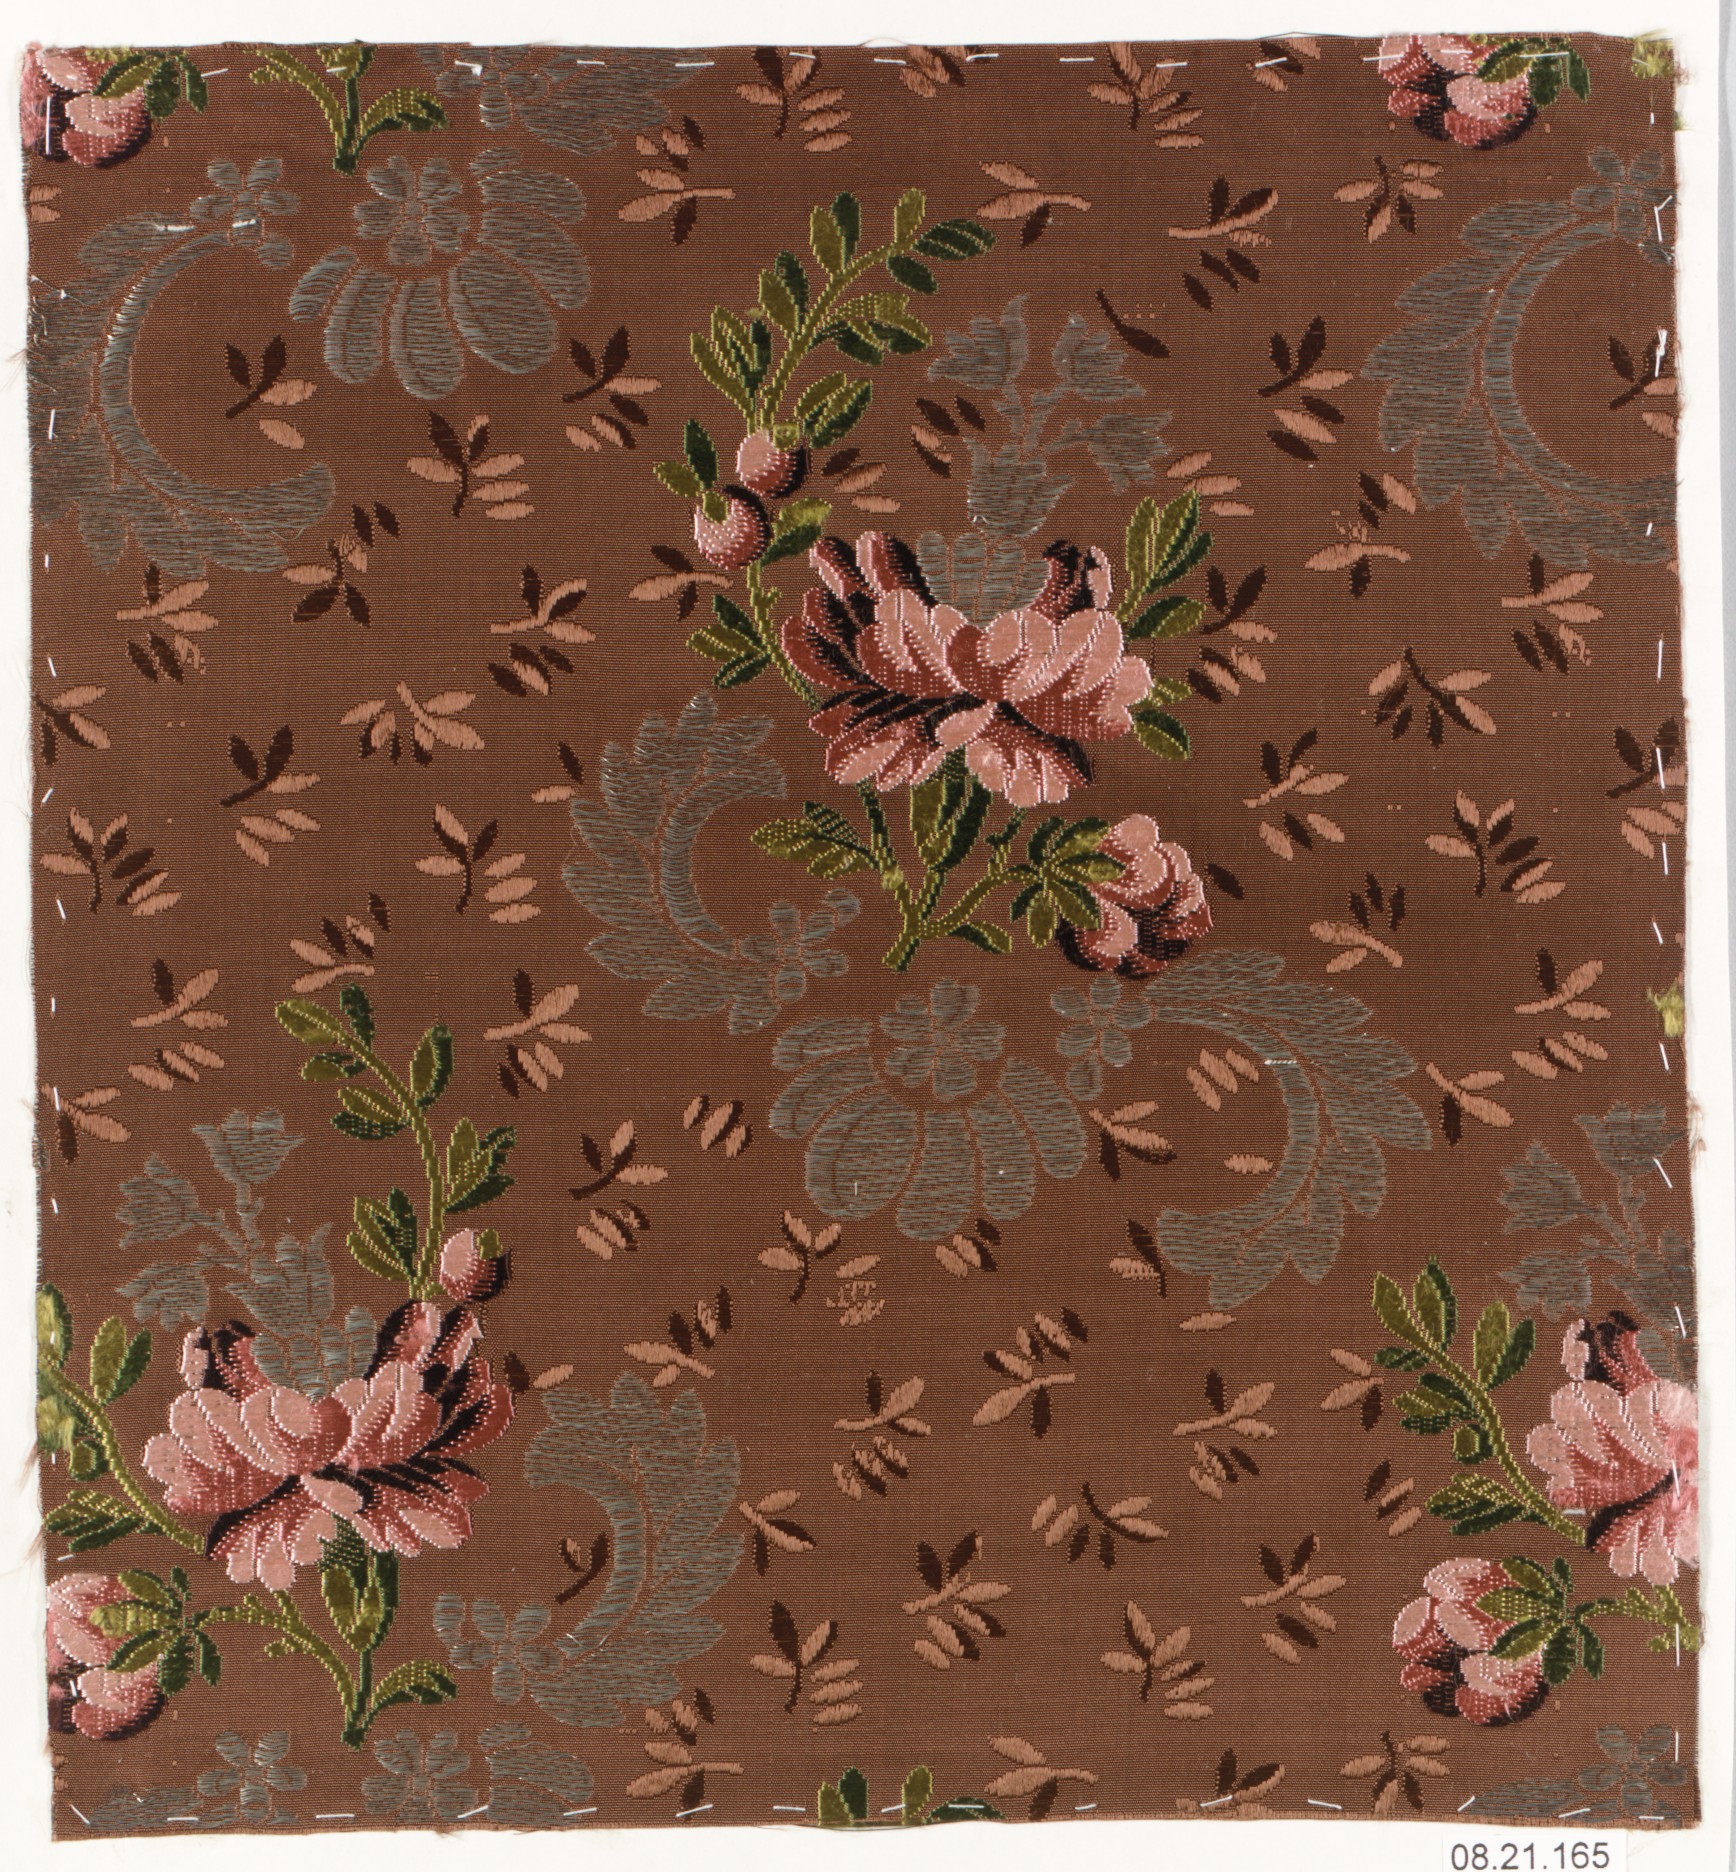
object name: textile sample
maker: Anonymous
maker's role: designer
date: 1900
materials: silk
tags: flowers